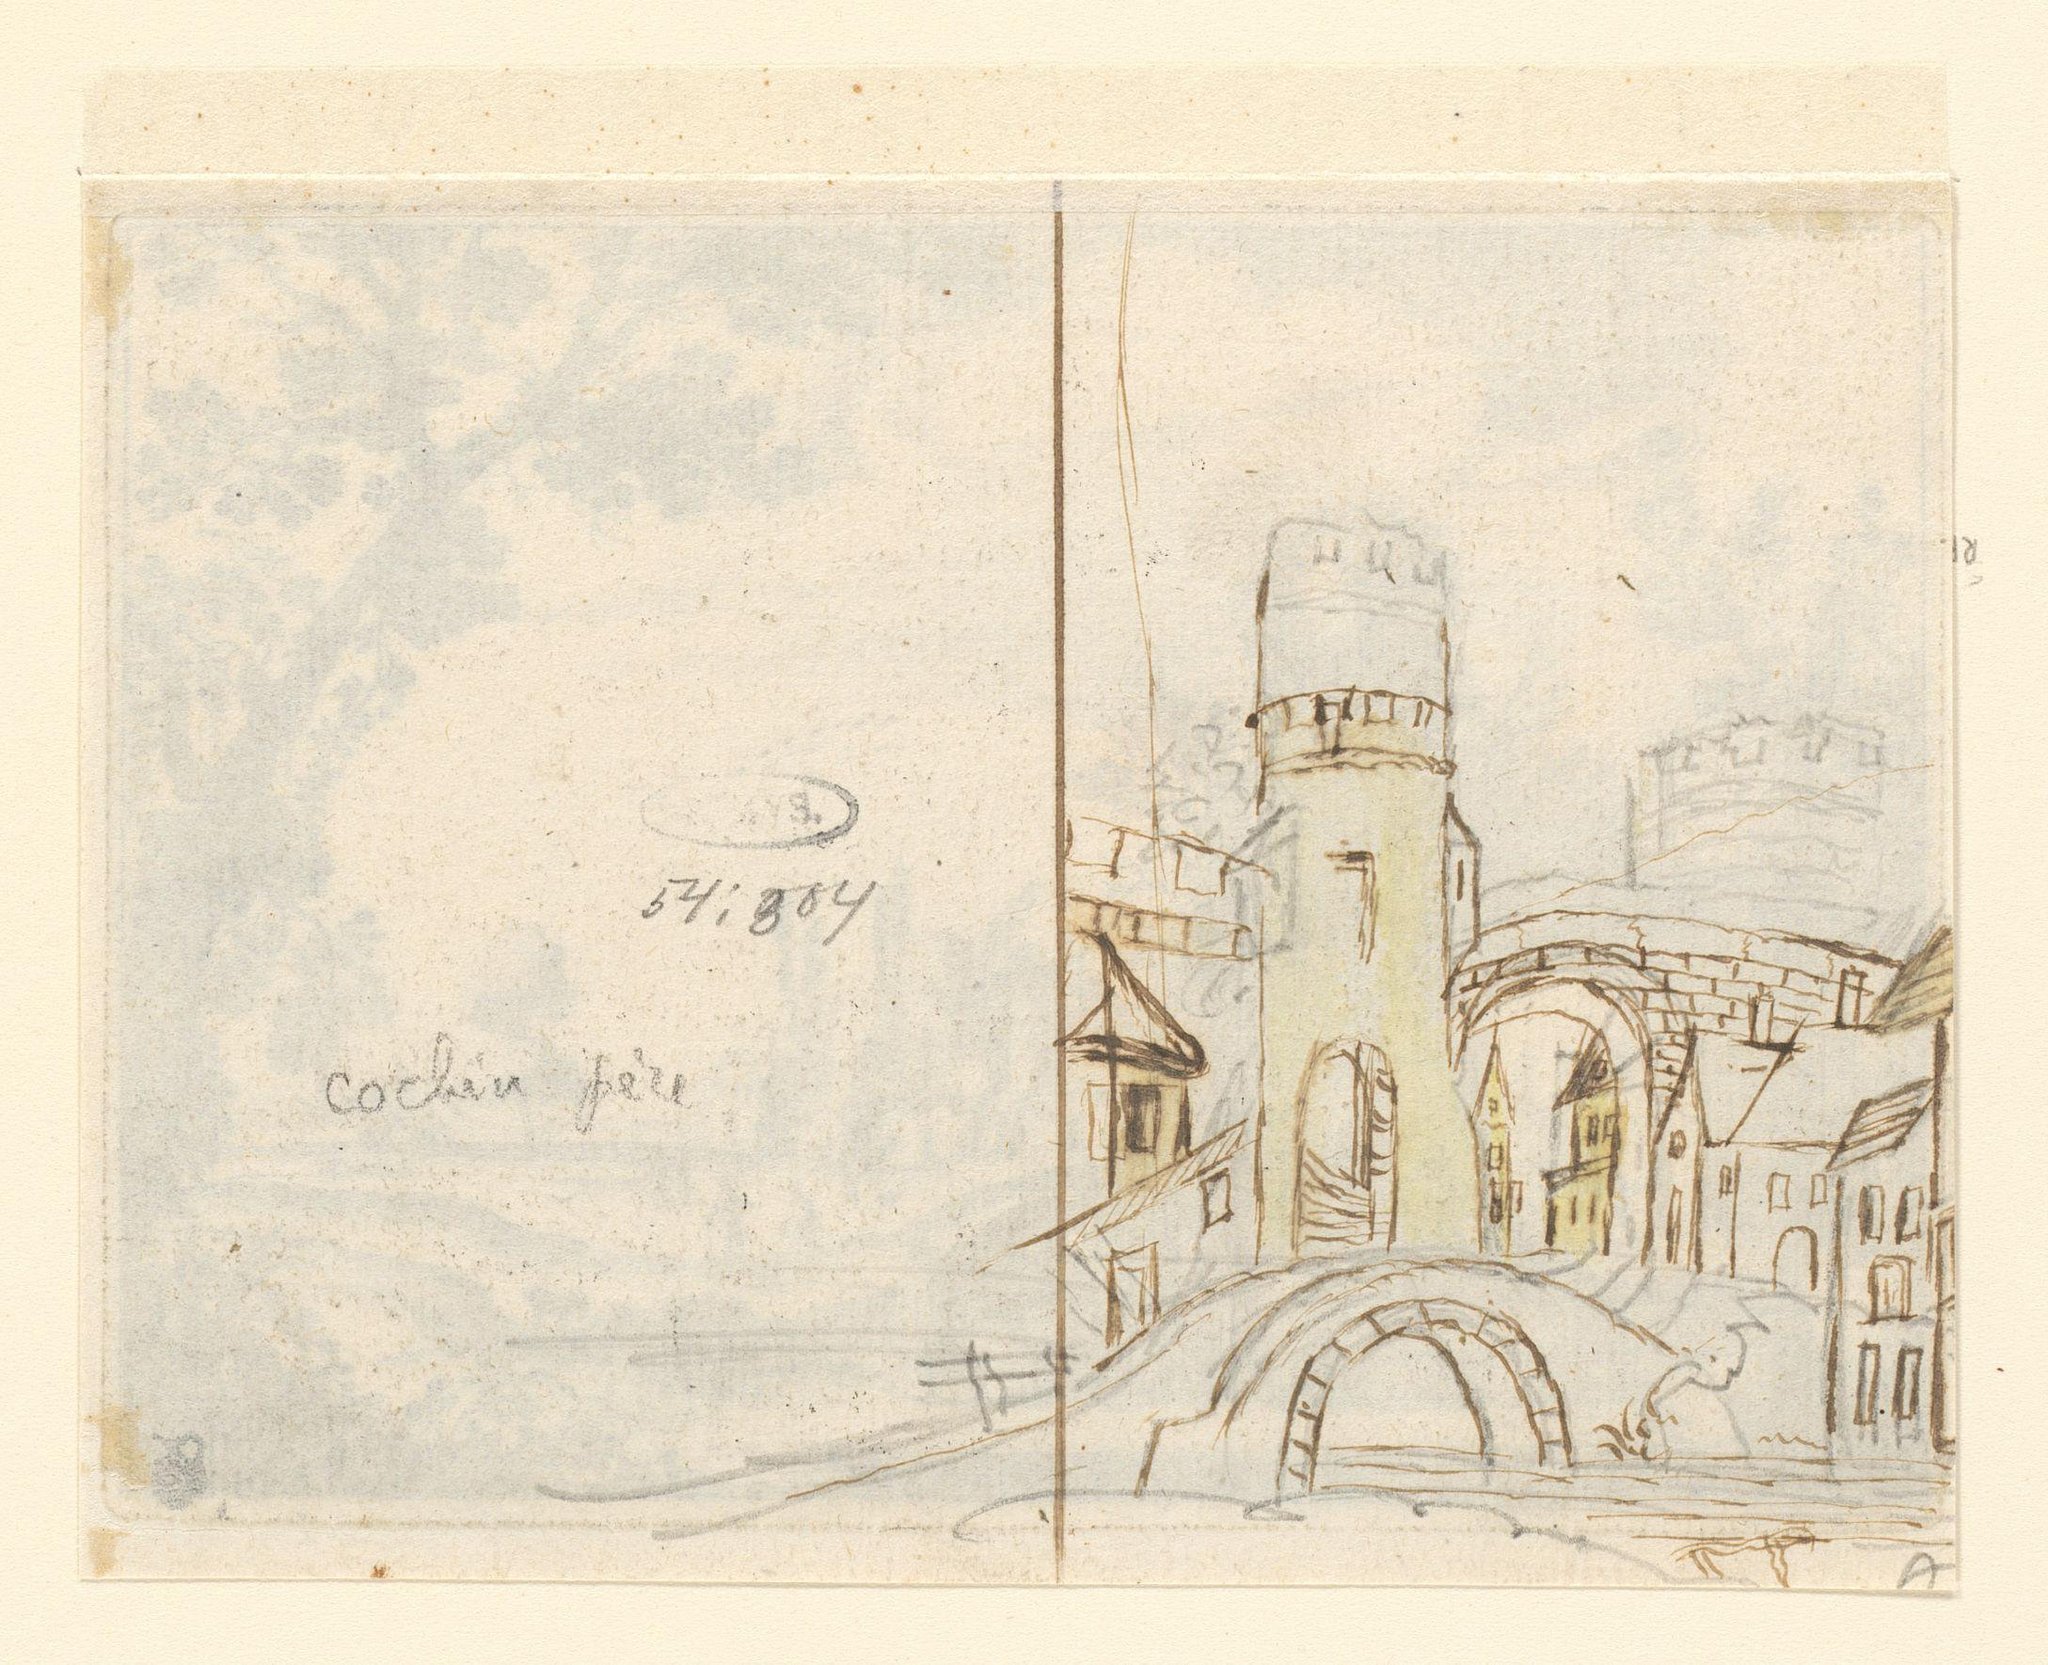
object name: drawing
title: Zicht op een stad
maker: Anonymous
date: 1620-1698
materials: ink, paper, pencil, watercolor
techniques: brush, pen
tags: towers ~ fortified city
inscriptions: collector's mark: Lugt 2228